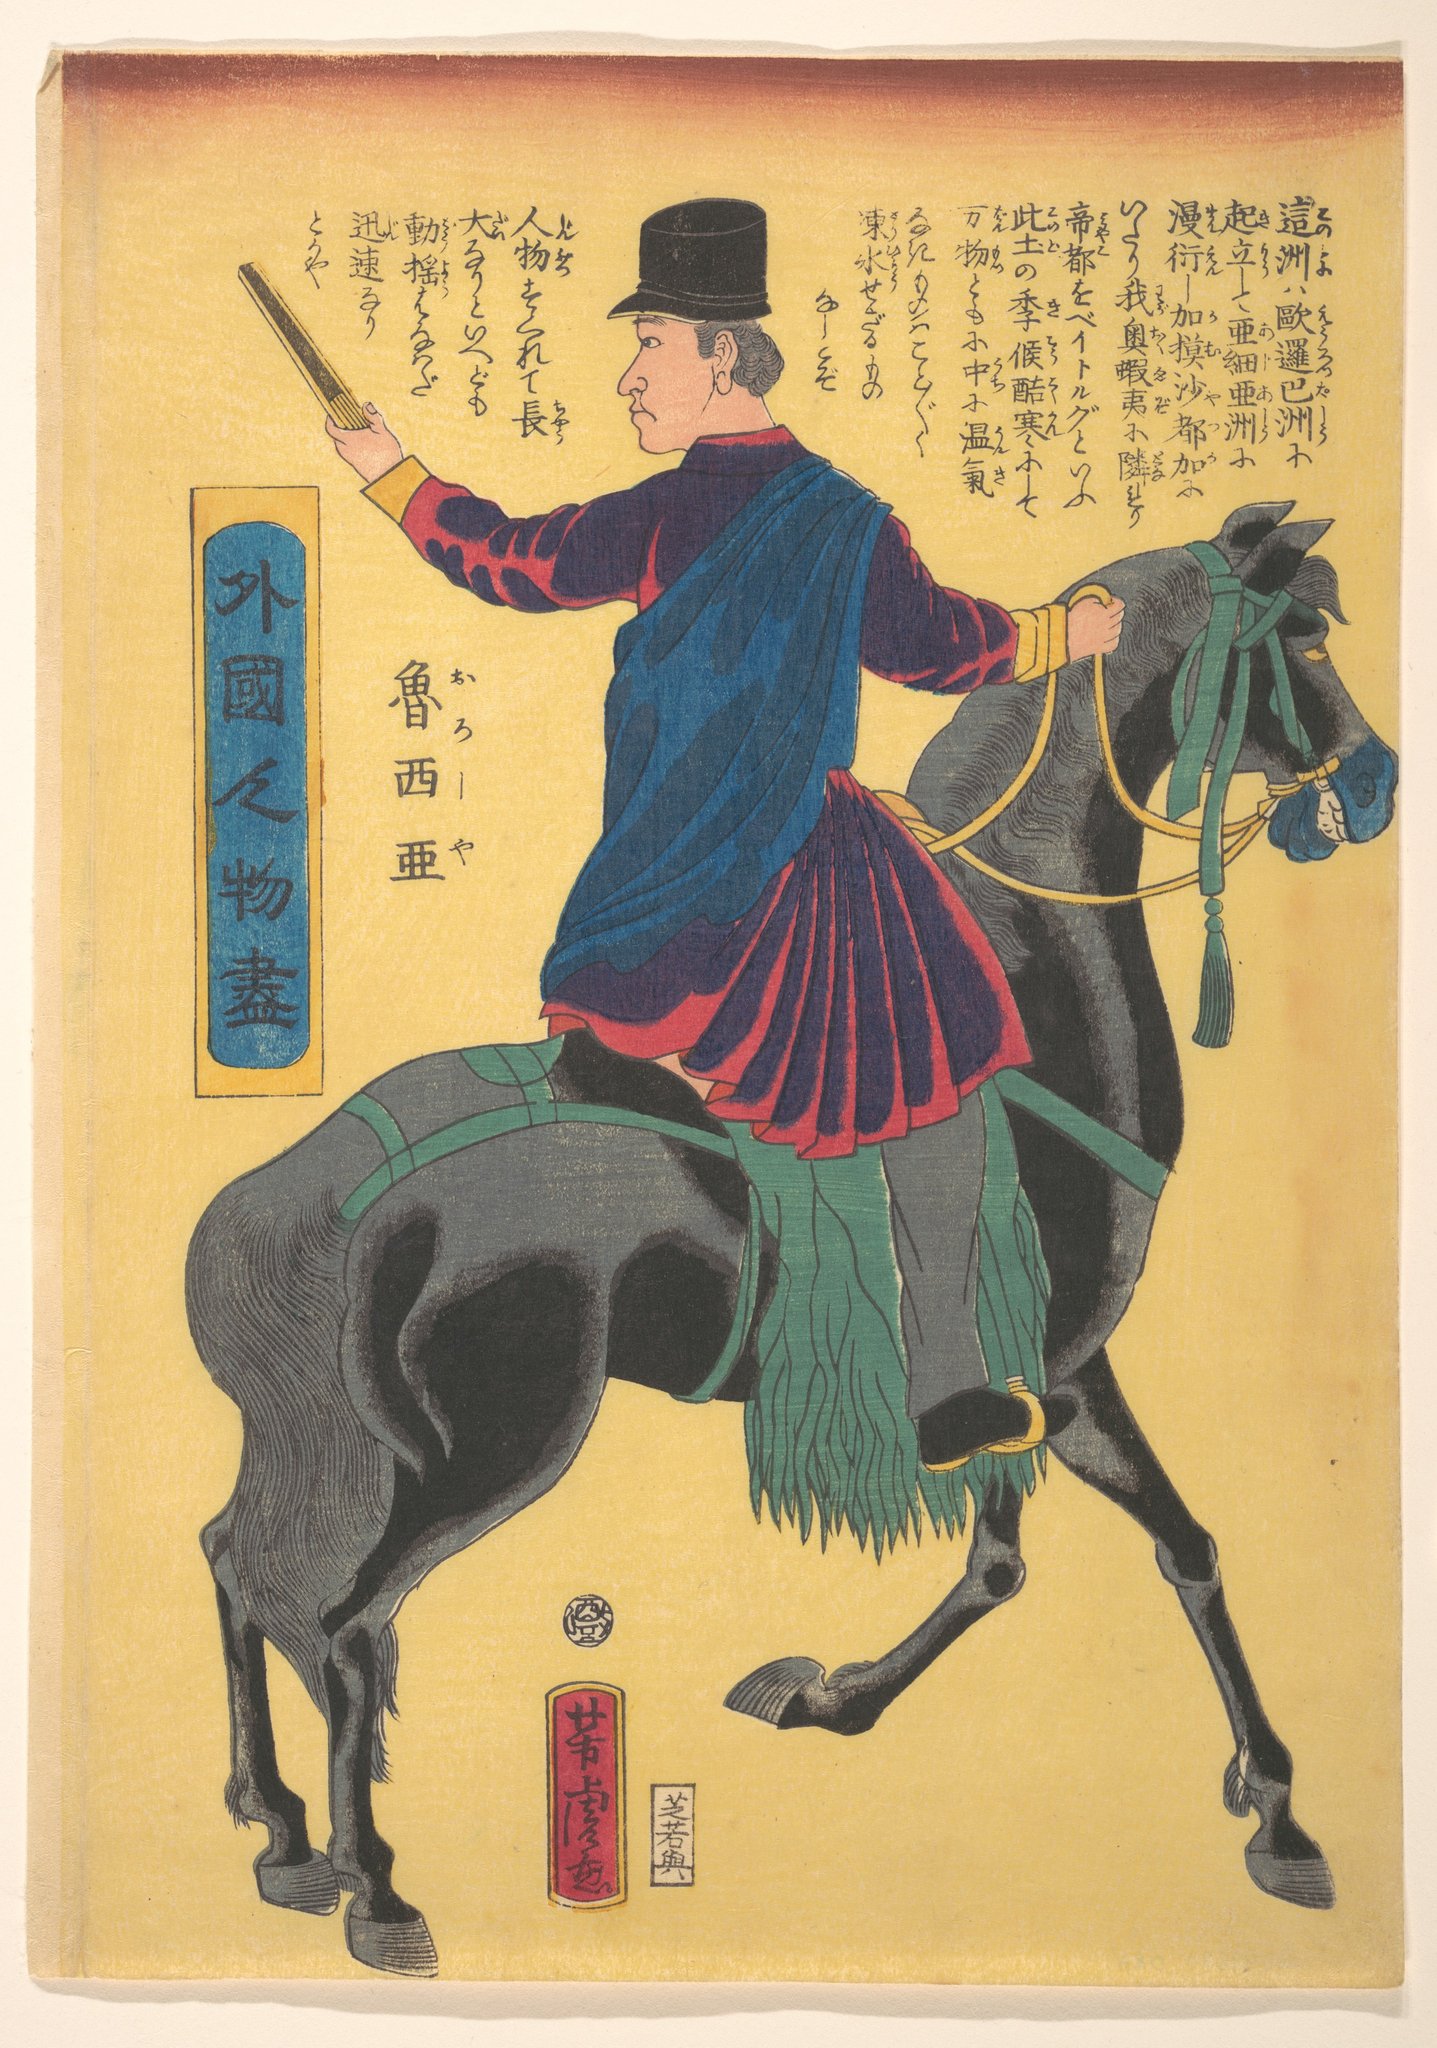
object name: print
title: Mounted Russian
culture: japanese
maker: utagawa yoshitora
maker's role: artist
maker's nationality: japanese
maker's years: 1845-1880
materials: ink, paper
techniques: woodblock print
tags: horses